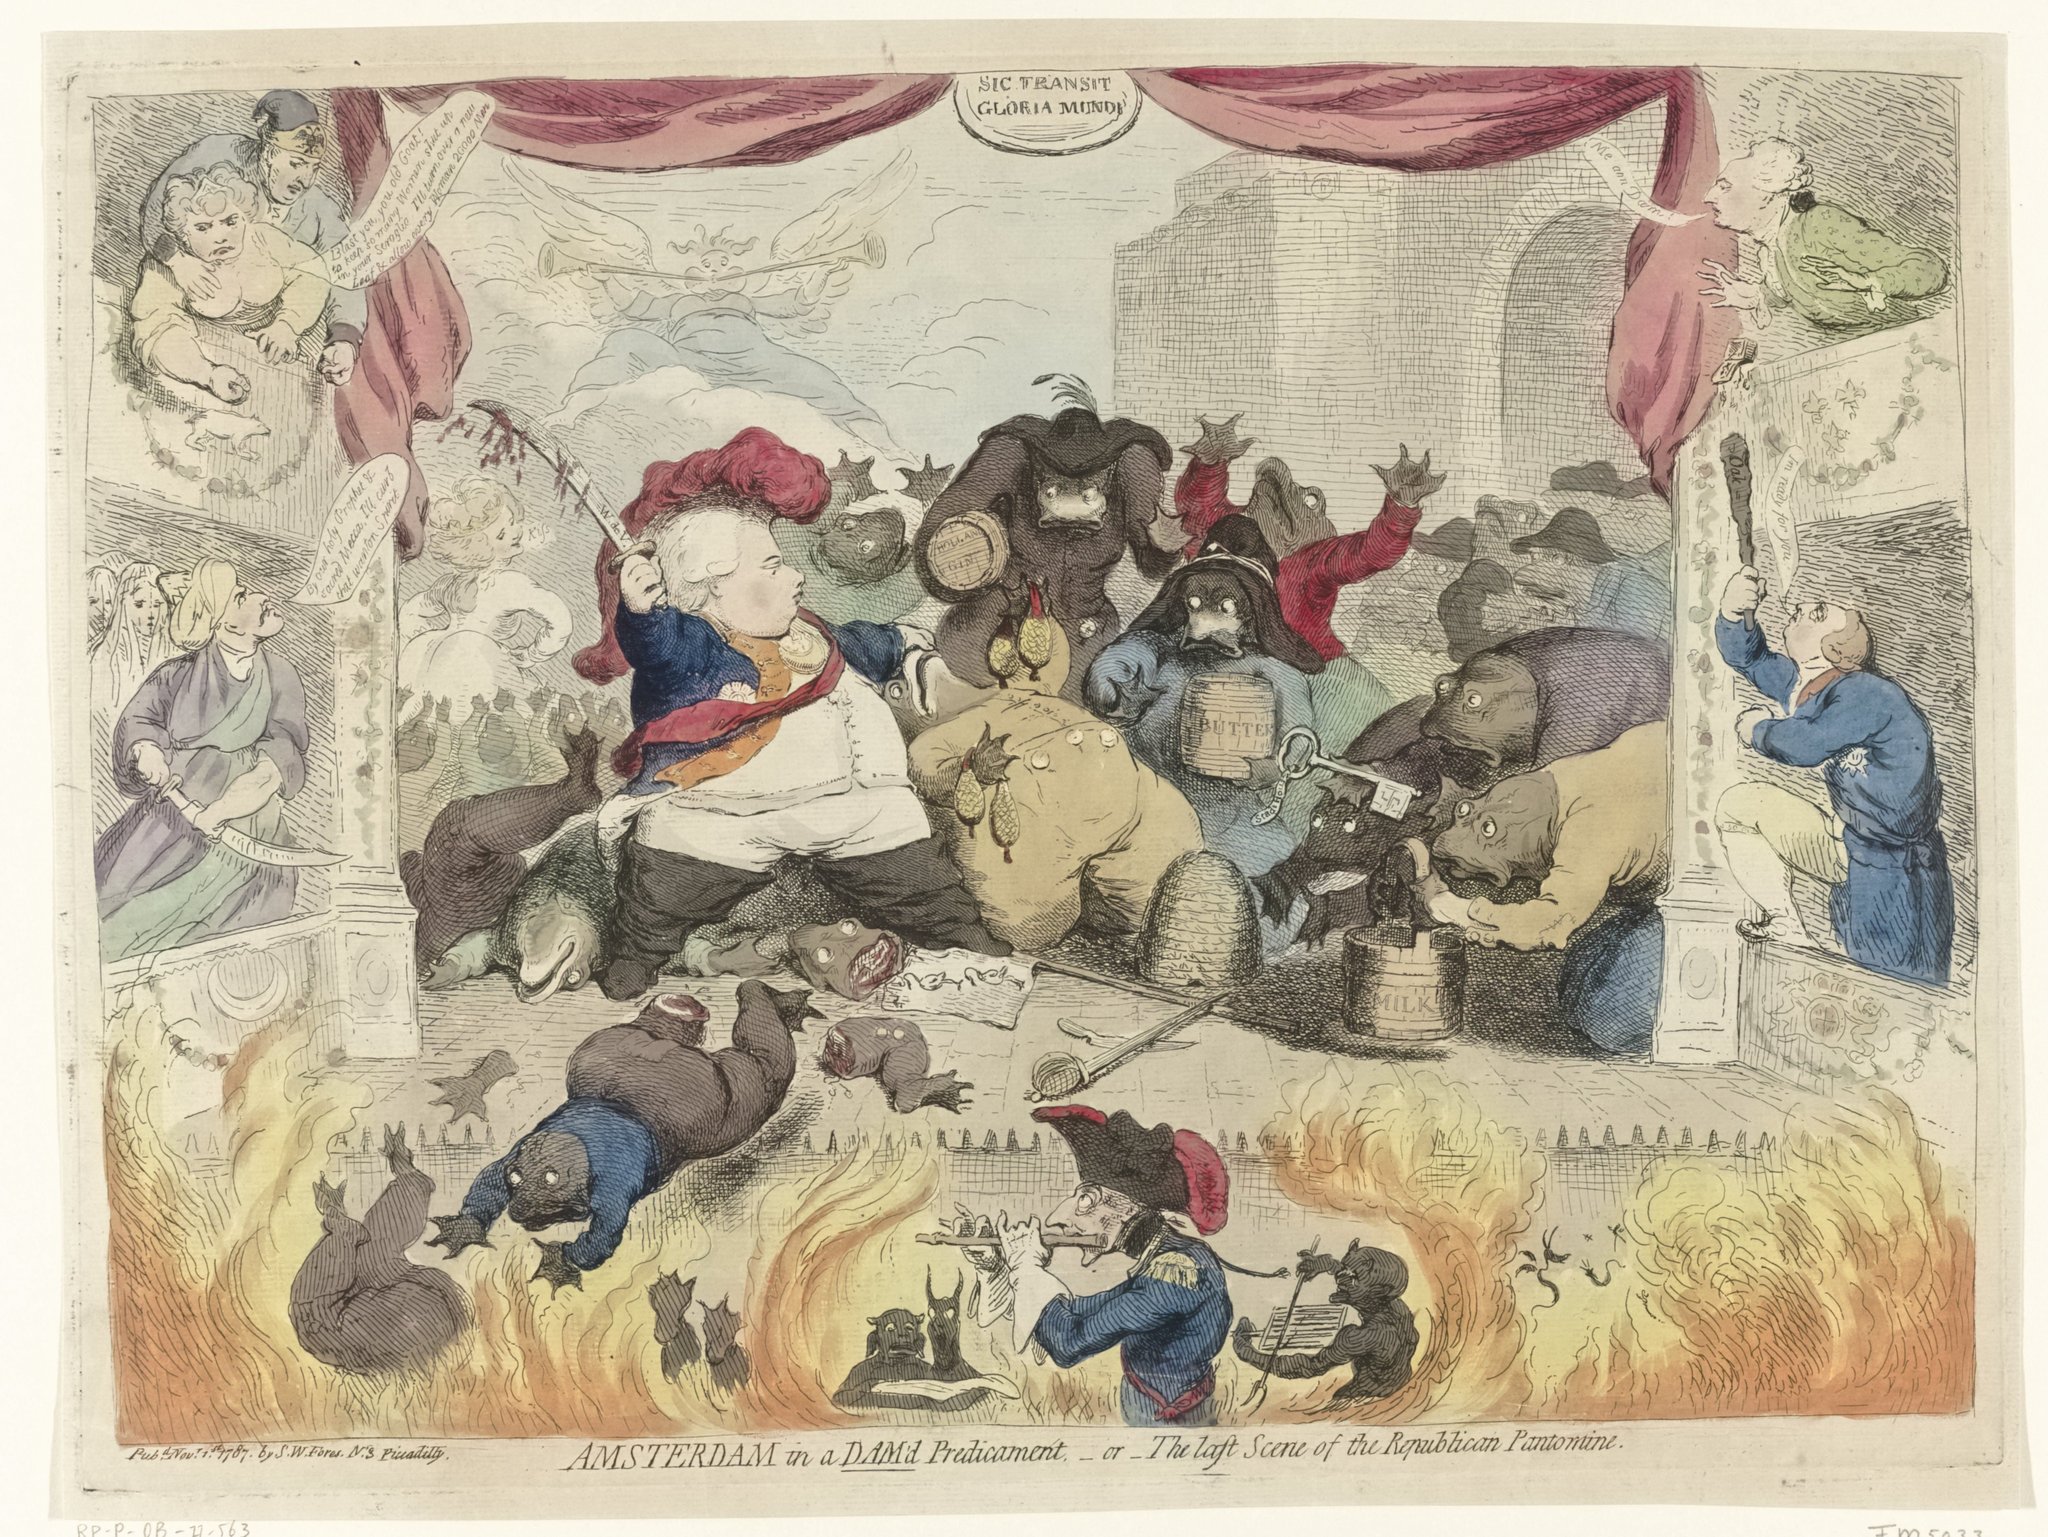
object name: print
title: Amsterdam in a dam’d predicament, – or – The Last Scene of the Republican Pantomime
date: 1787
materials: paper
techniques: etching, hand coloring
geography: london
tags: william v (prince of orange), vienna, jozef ii (duits keizer), berlin, frederick ii (king of prussia), catharina de grote, paris, lodewijk xvi (koning van frankrijk), london, george iii (koning van het verenigd koninkrijk), tailless amphibians: frog, theatre, theatrical performance, hell and purgatory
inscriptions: title: ‘Amsterdam in a DAM'd Predicament - or - The last Scene of the Republican Pantomine’, collector's mark: Lugt 2228, address: ‘Pub. Nov. 1st. 1787 by S.W. Fores N. 5 Piccadilly’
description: In this scene by the famous English caricaturist James Gillray, William V’s restoration as stadtholder after the Prussian invasion has become a bloody stage play. The British watch these foolish Continental antics with their usual amused aloofness. The stadtholder unleashes a bloodbath among the Patriots – once more portrayed as frogs – whilst in the background Princess Wilhelmina of Prussia allows them to kiss her bottom.